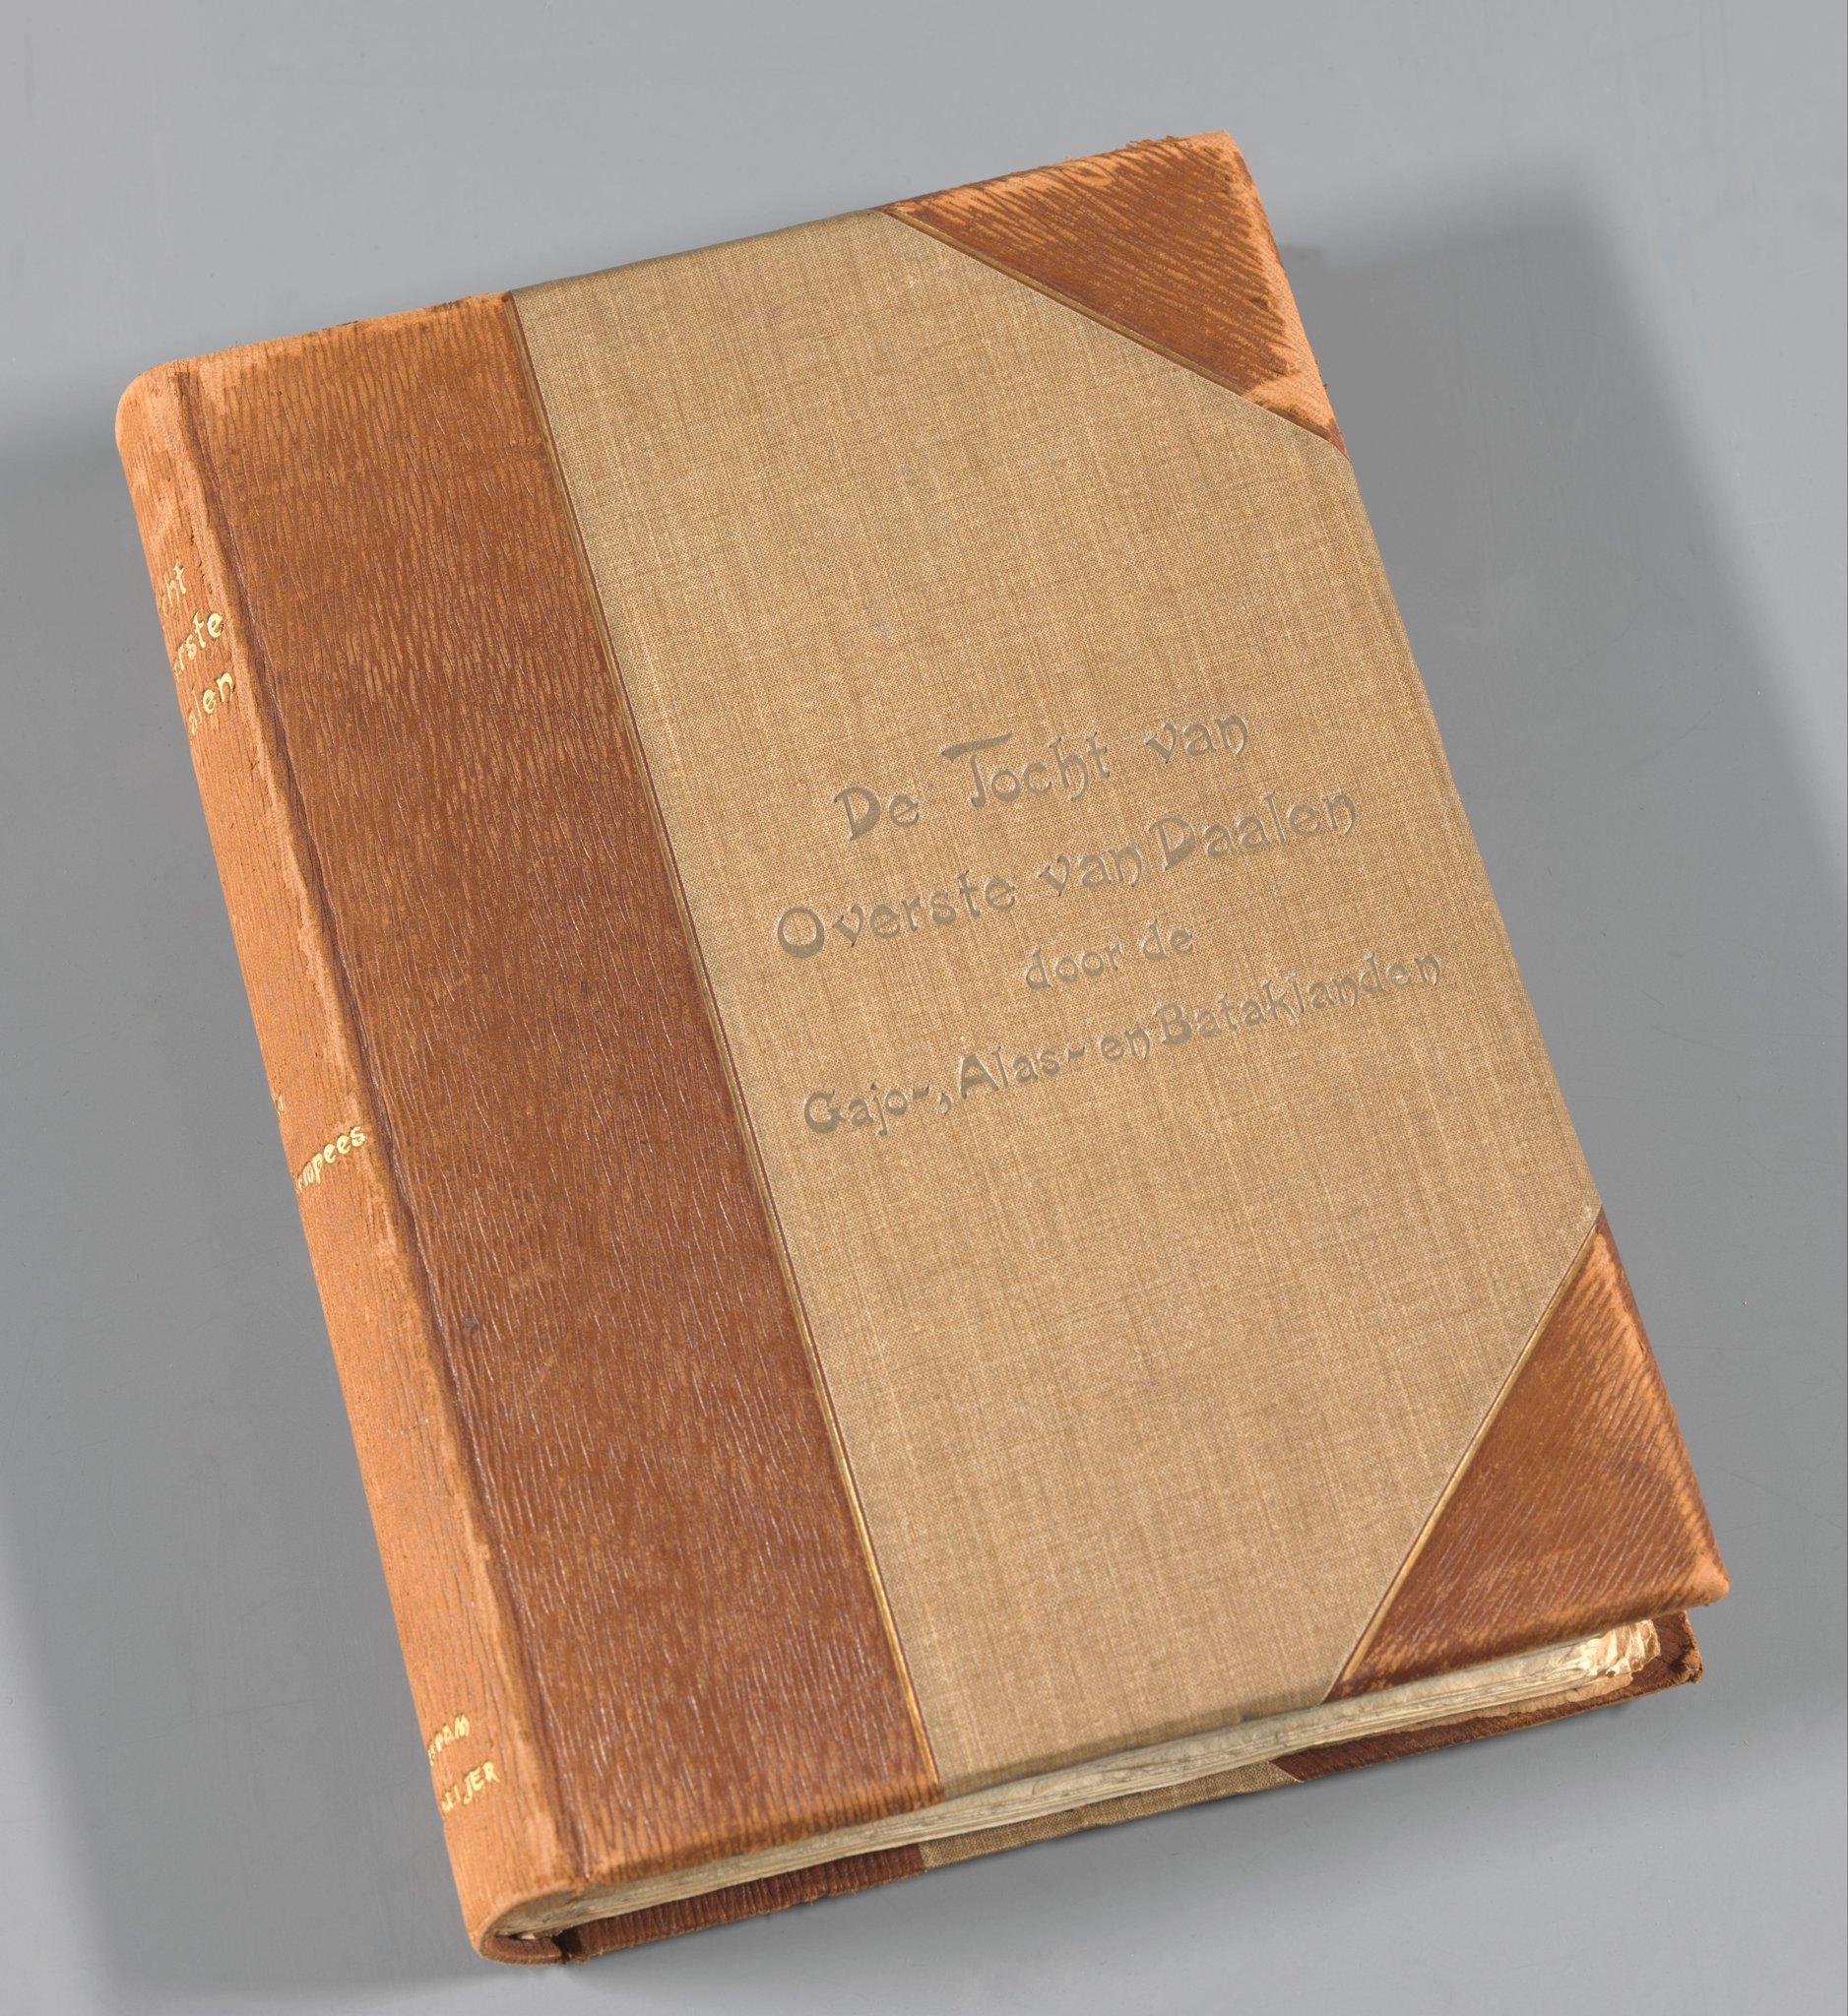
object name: book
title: De tocht van Overste van Daalen door de Gajo-, Alas- en Bataklanden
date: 1905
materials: leather, linen, paper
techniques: bookbinding, printing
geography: amsterdam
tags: dutch east indies, the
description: 265 pp van geschept papier in linnen band met leer versterkte rug en hoeken. Goud op snee. Met 29 foto's en 5 kaarten, Opschrift; 2de blad (handgeschreven): 'No. 5 der Weelde-uitgaaf / (get) J. C. Dalmeyer'.